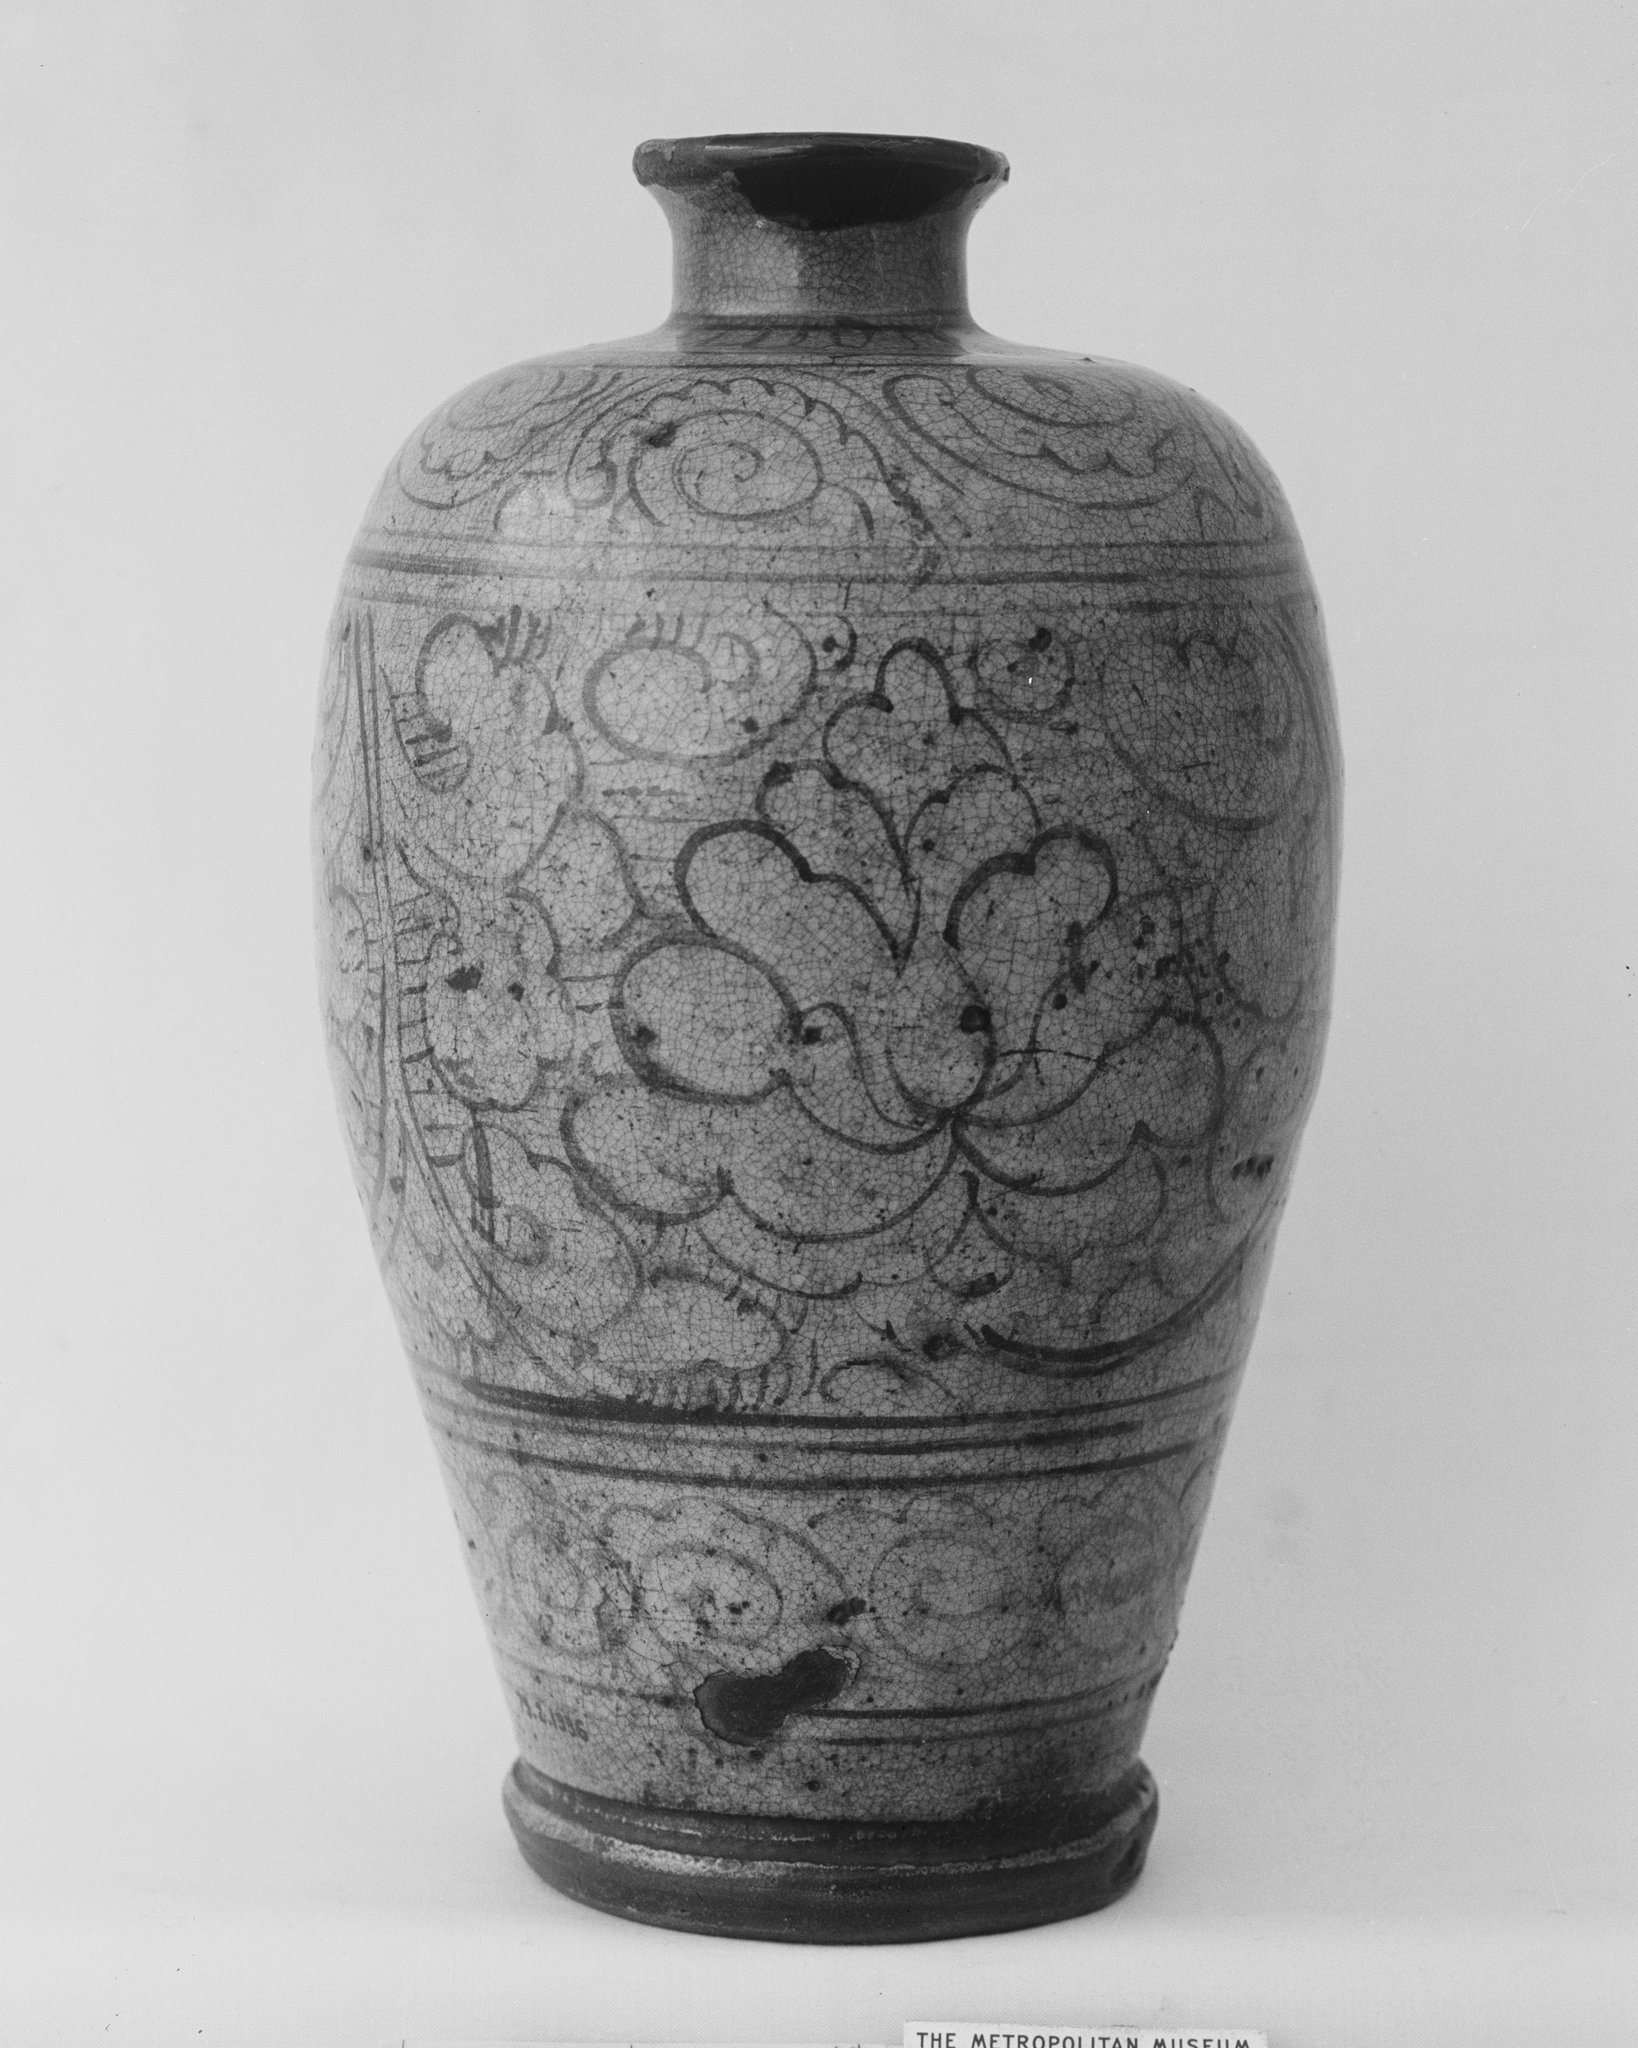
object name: vase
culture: chinese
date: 1271-1368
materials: glaze, stoneware